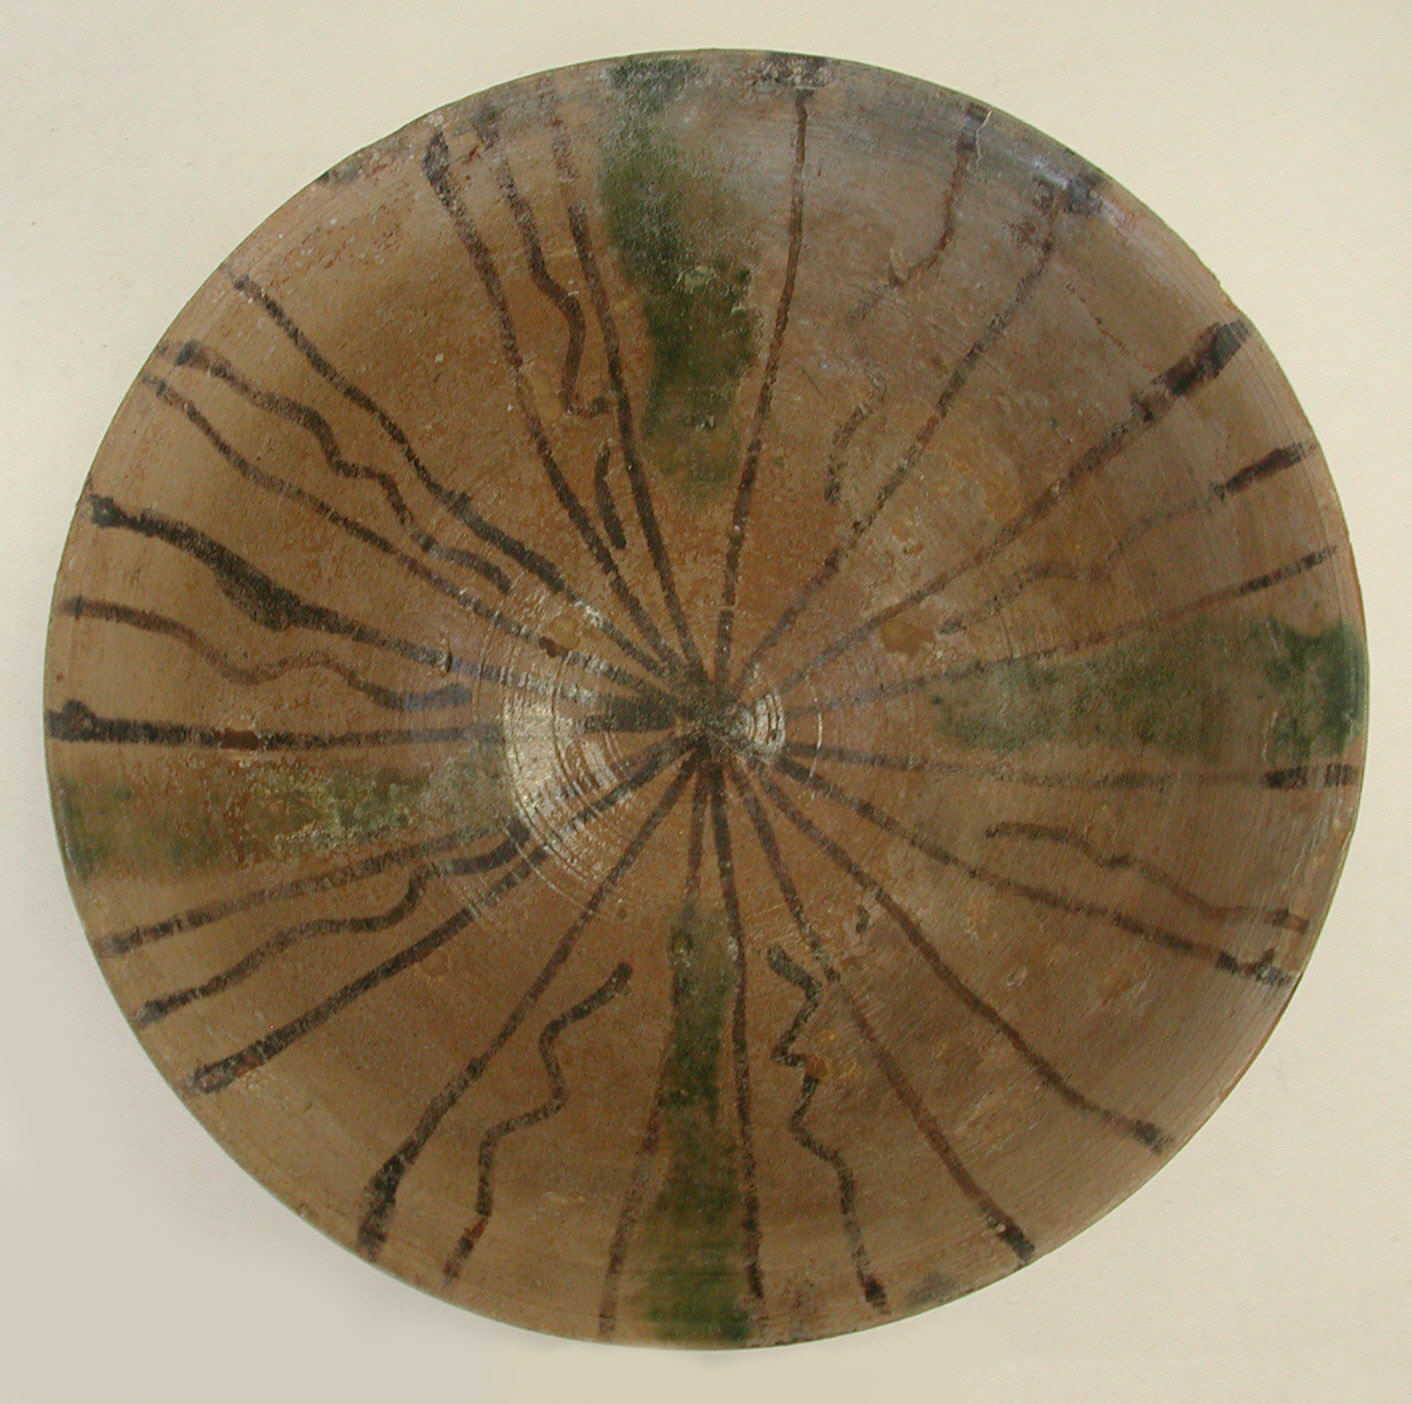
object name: bowl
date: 767-900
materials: earthenware, glaze, pigment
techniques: painting, polychrome, underglaze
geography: iran